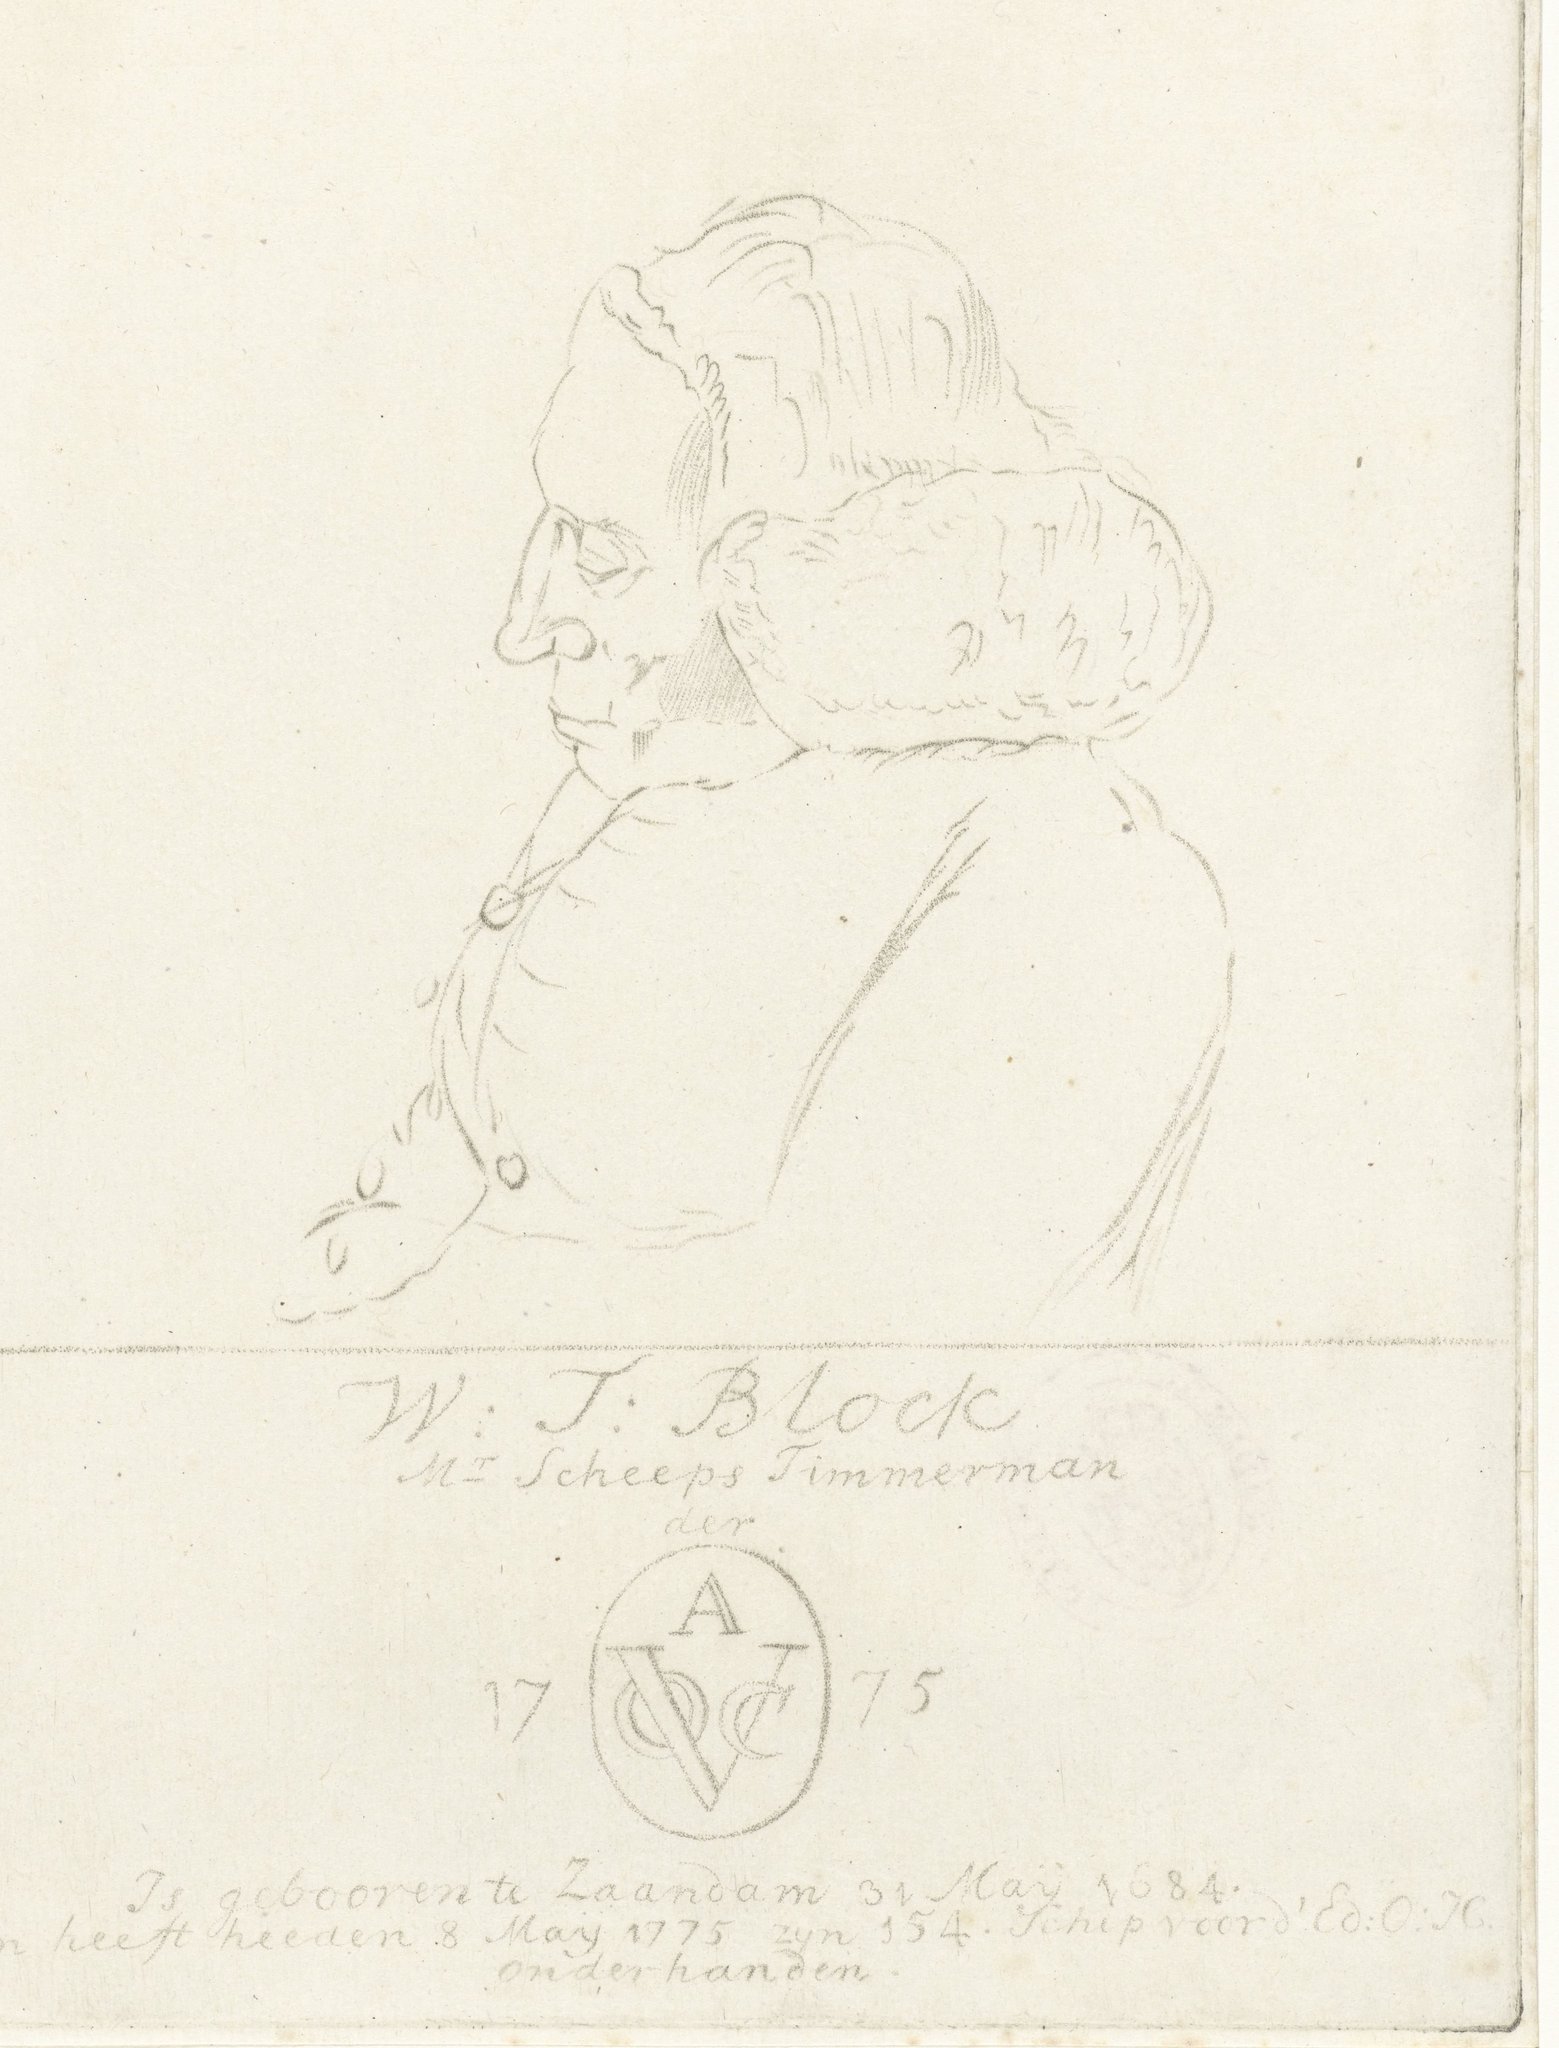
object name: print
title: Portret van Willem Teunisz. Block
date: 1775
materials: paper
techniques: printmaking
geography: amsterdam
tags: scheepsbouwer, willem teunisz. block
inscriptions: collector's mark: Lugt 240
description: Portret van Willem Teunisz. Block, scheepstimmerman voor de VOC.